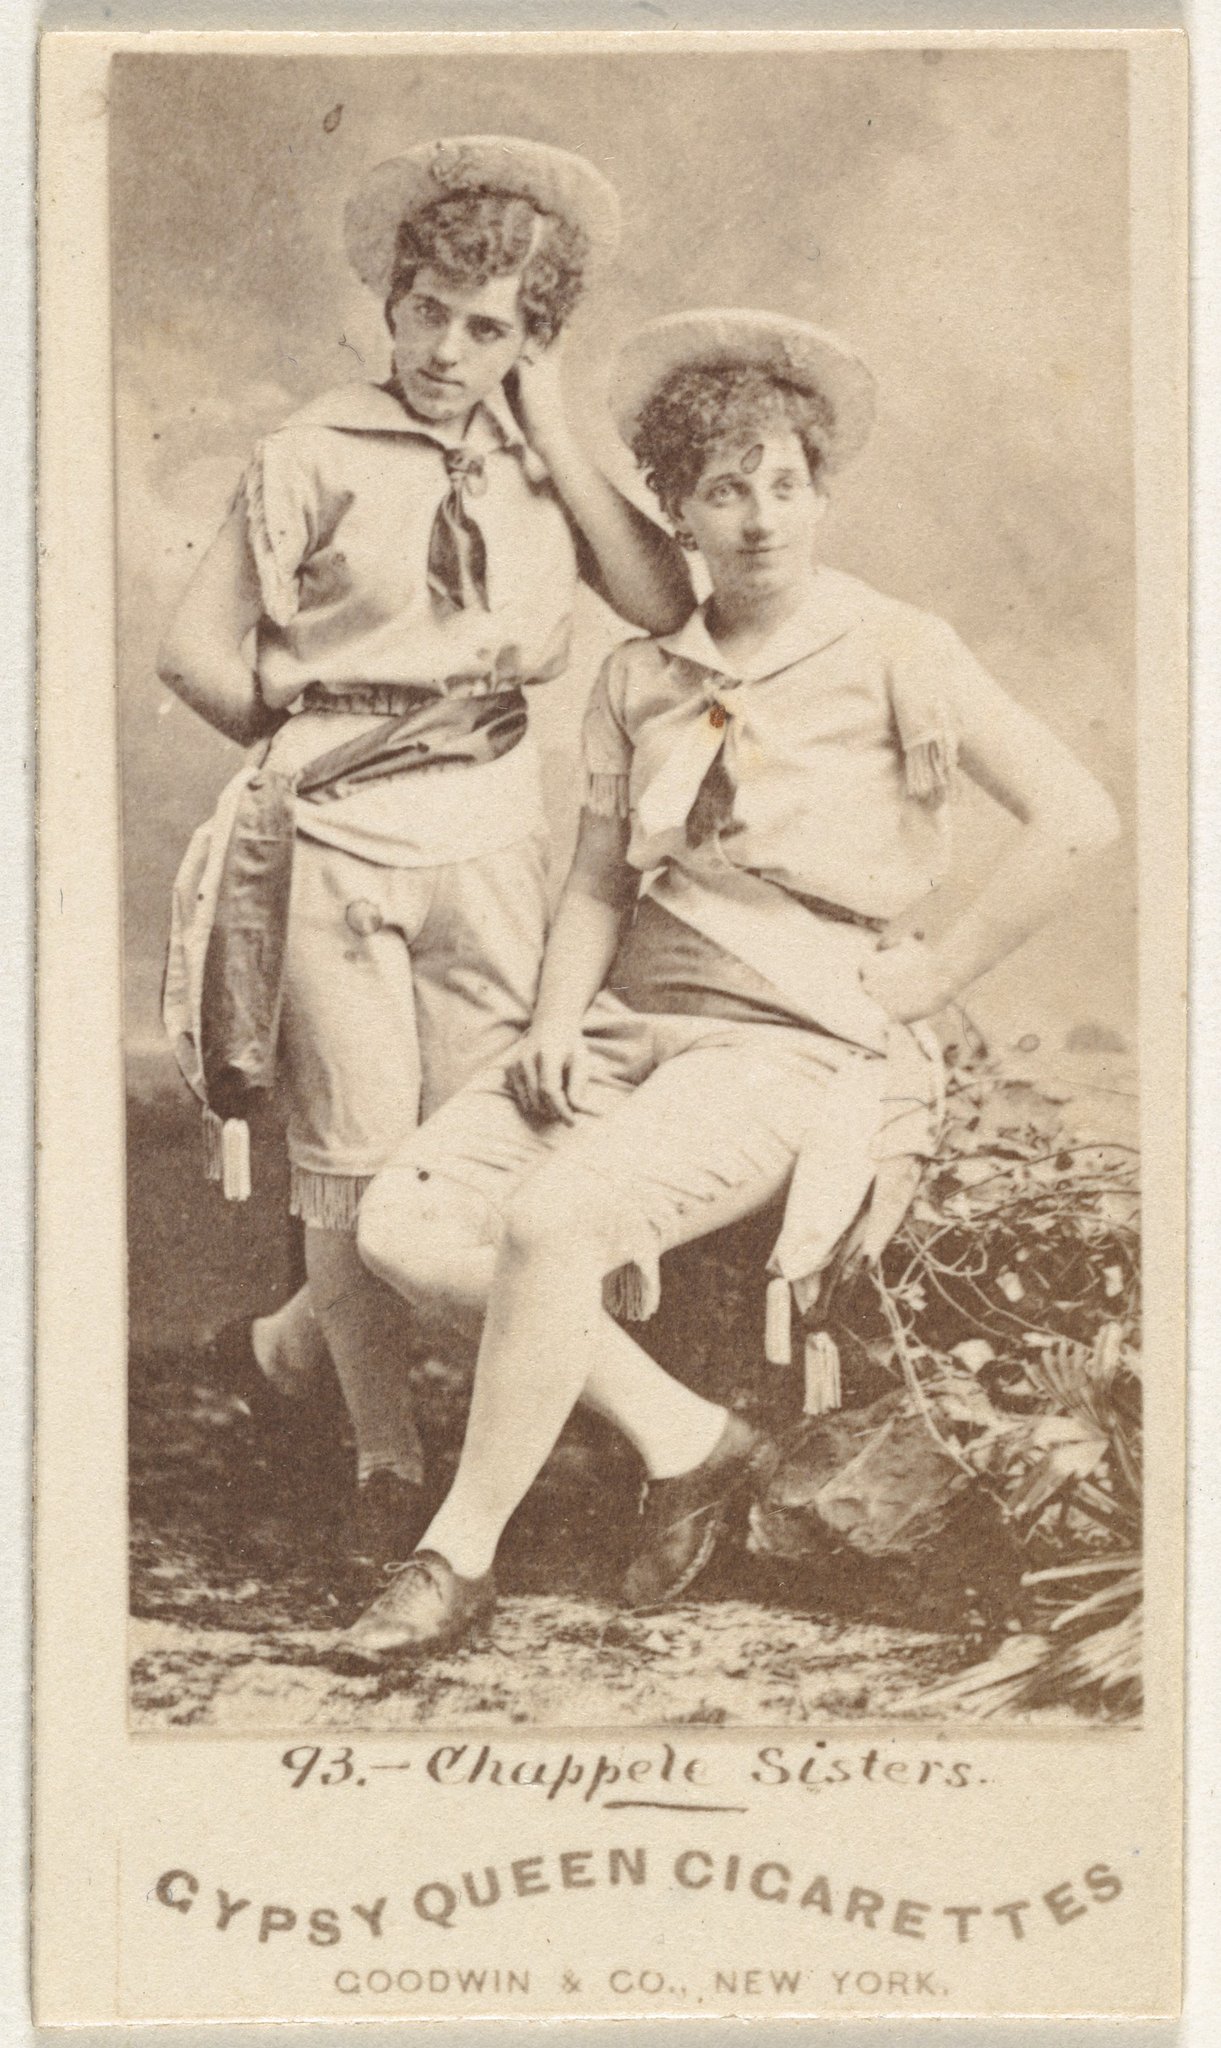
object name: photograph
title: Chappele Sisters, from the Actors and Actresses series (N171) for Gypsy Queen Cigarettes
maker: goodwin & company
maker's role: publisher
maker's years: 1850-1950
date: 1886-1890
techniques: albumen silver print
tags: portraits,women,actresses